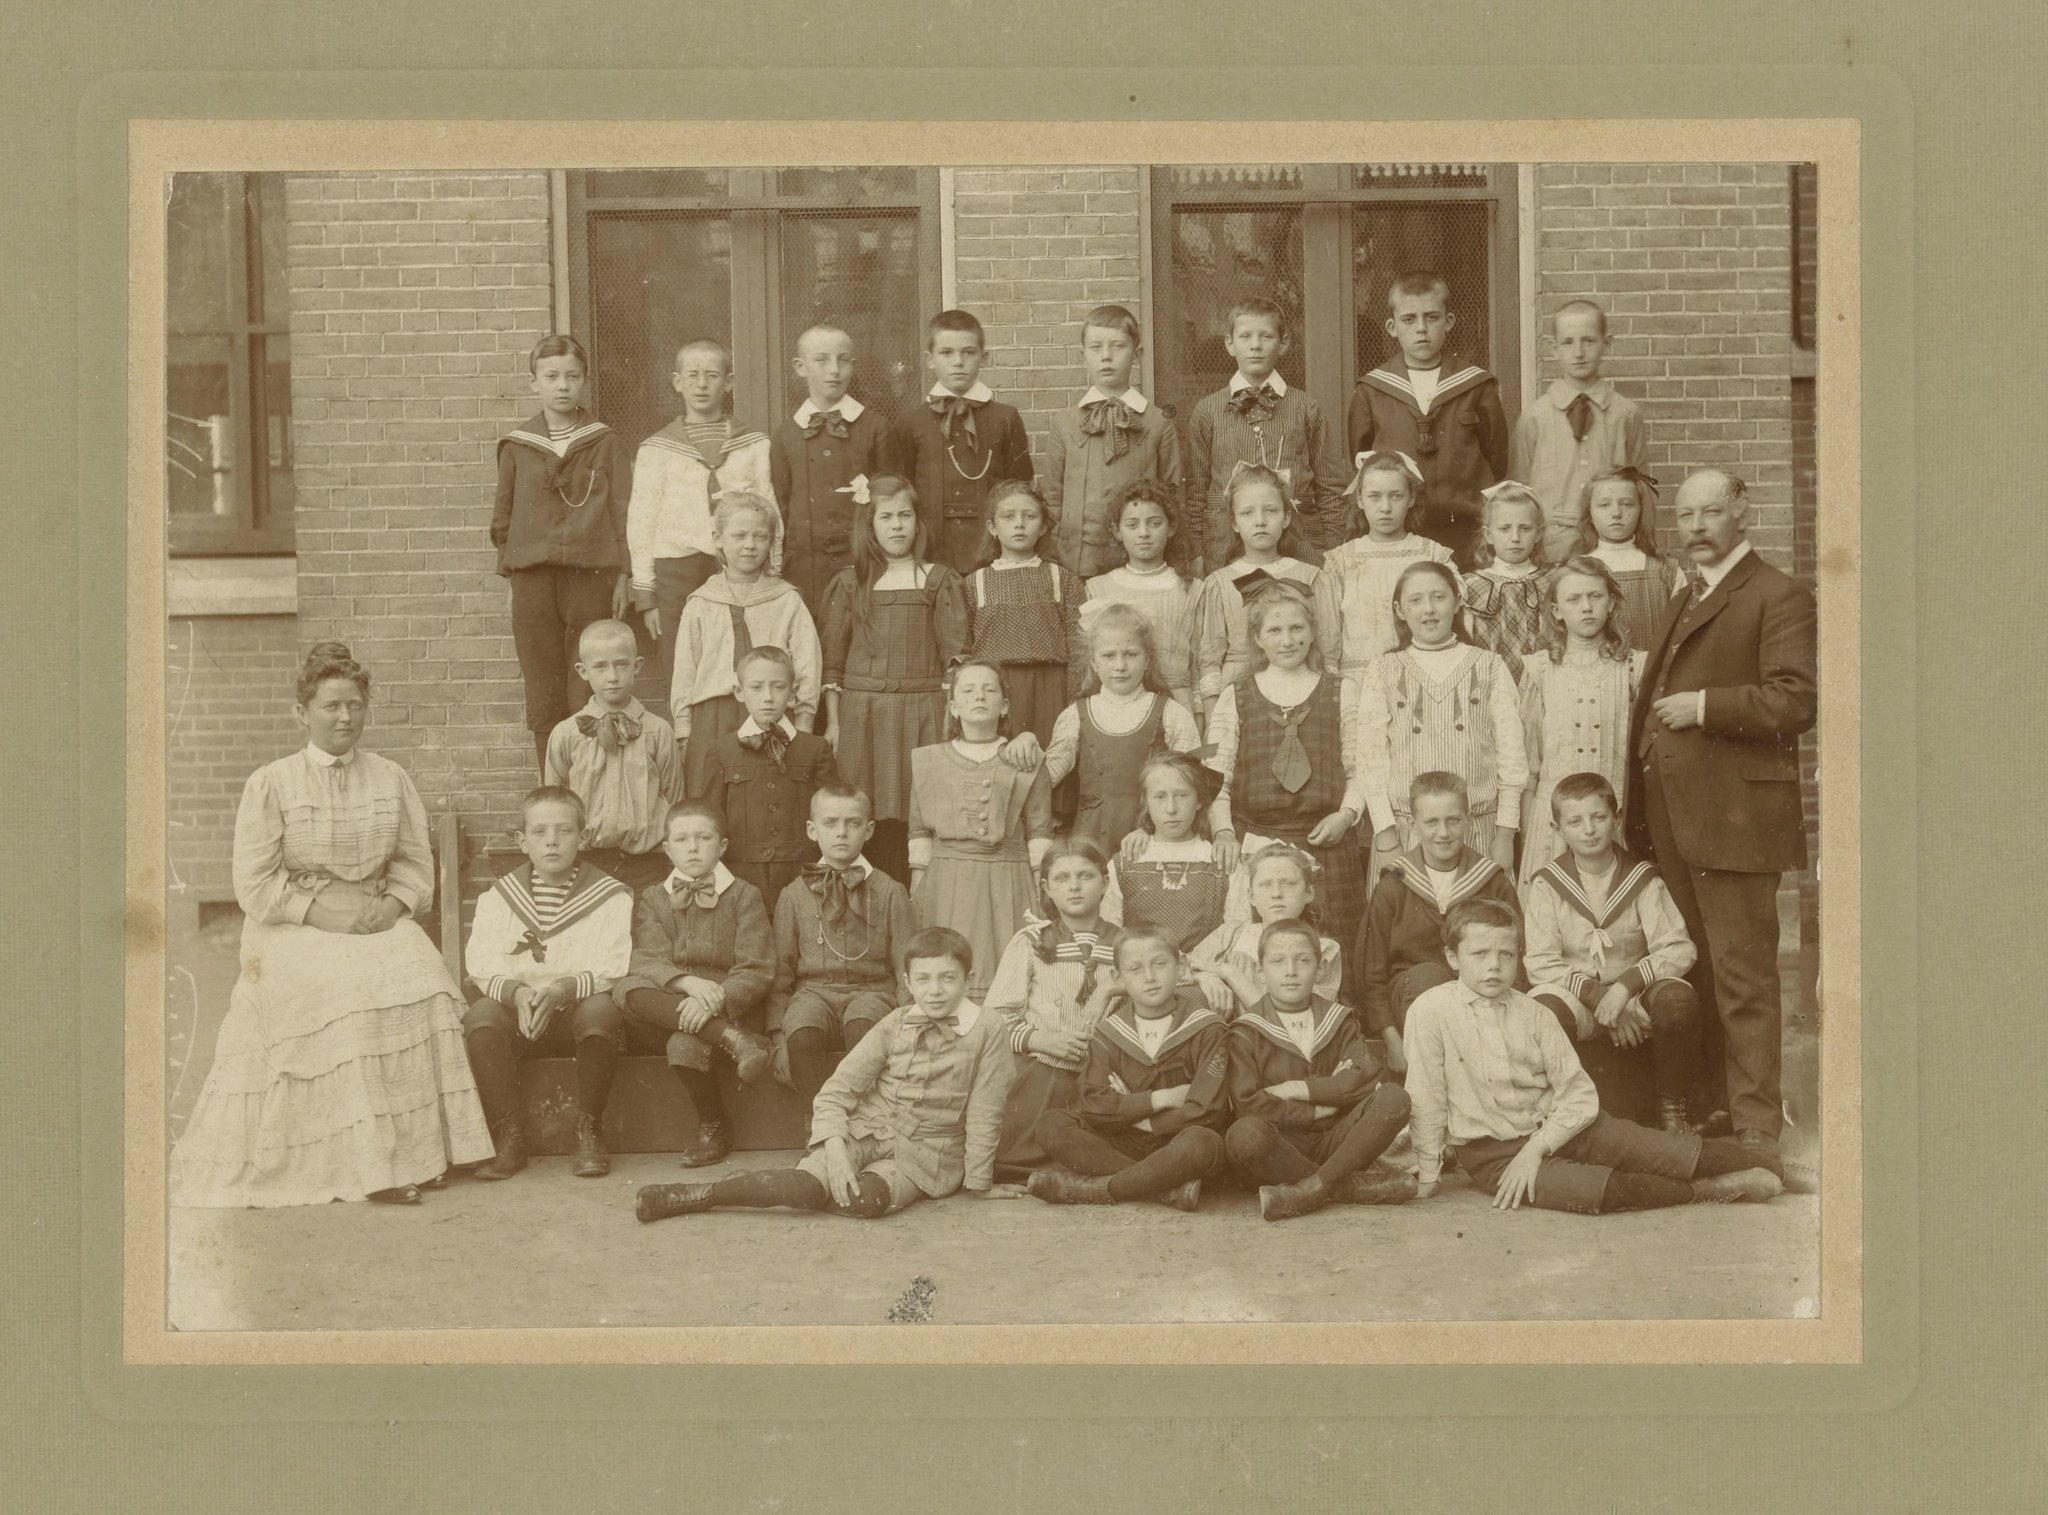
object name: photograph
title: Schoolfoto van kinderen buiten bij school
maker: Anonymous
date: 1910-1920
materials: cardboard, photographic support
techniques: collodion silver print